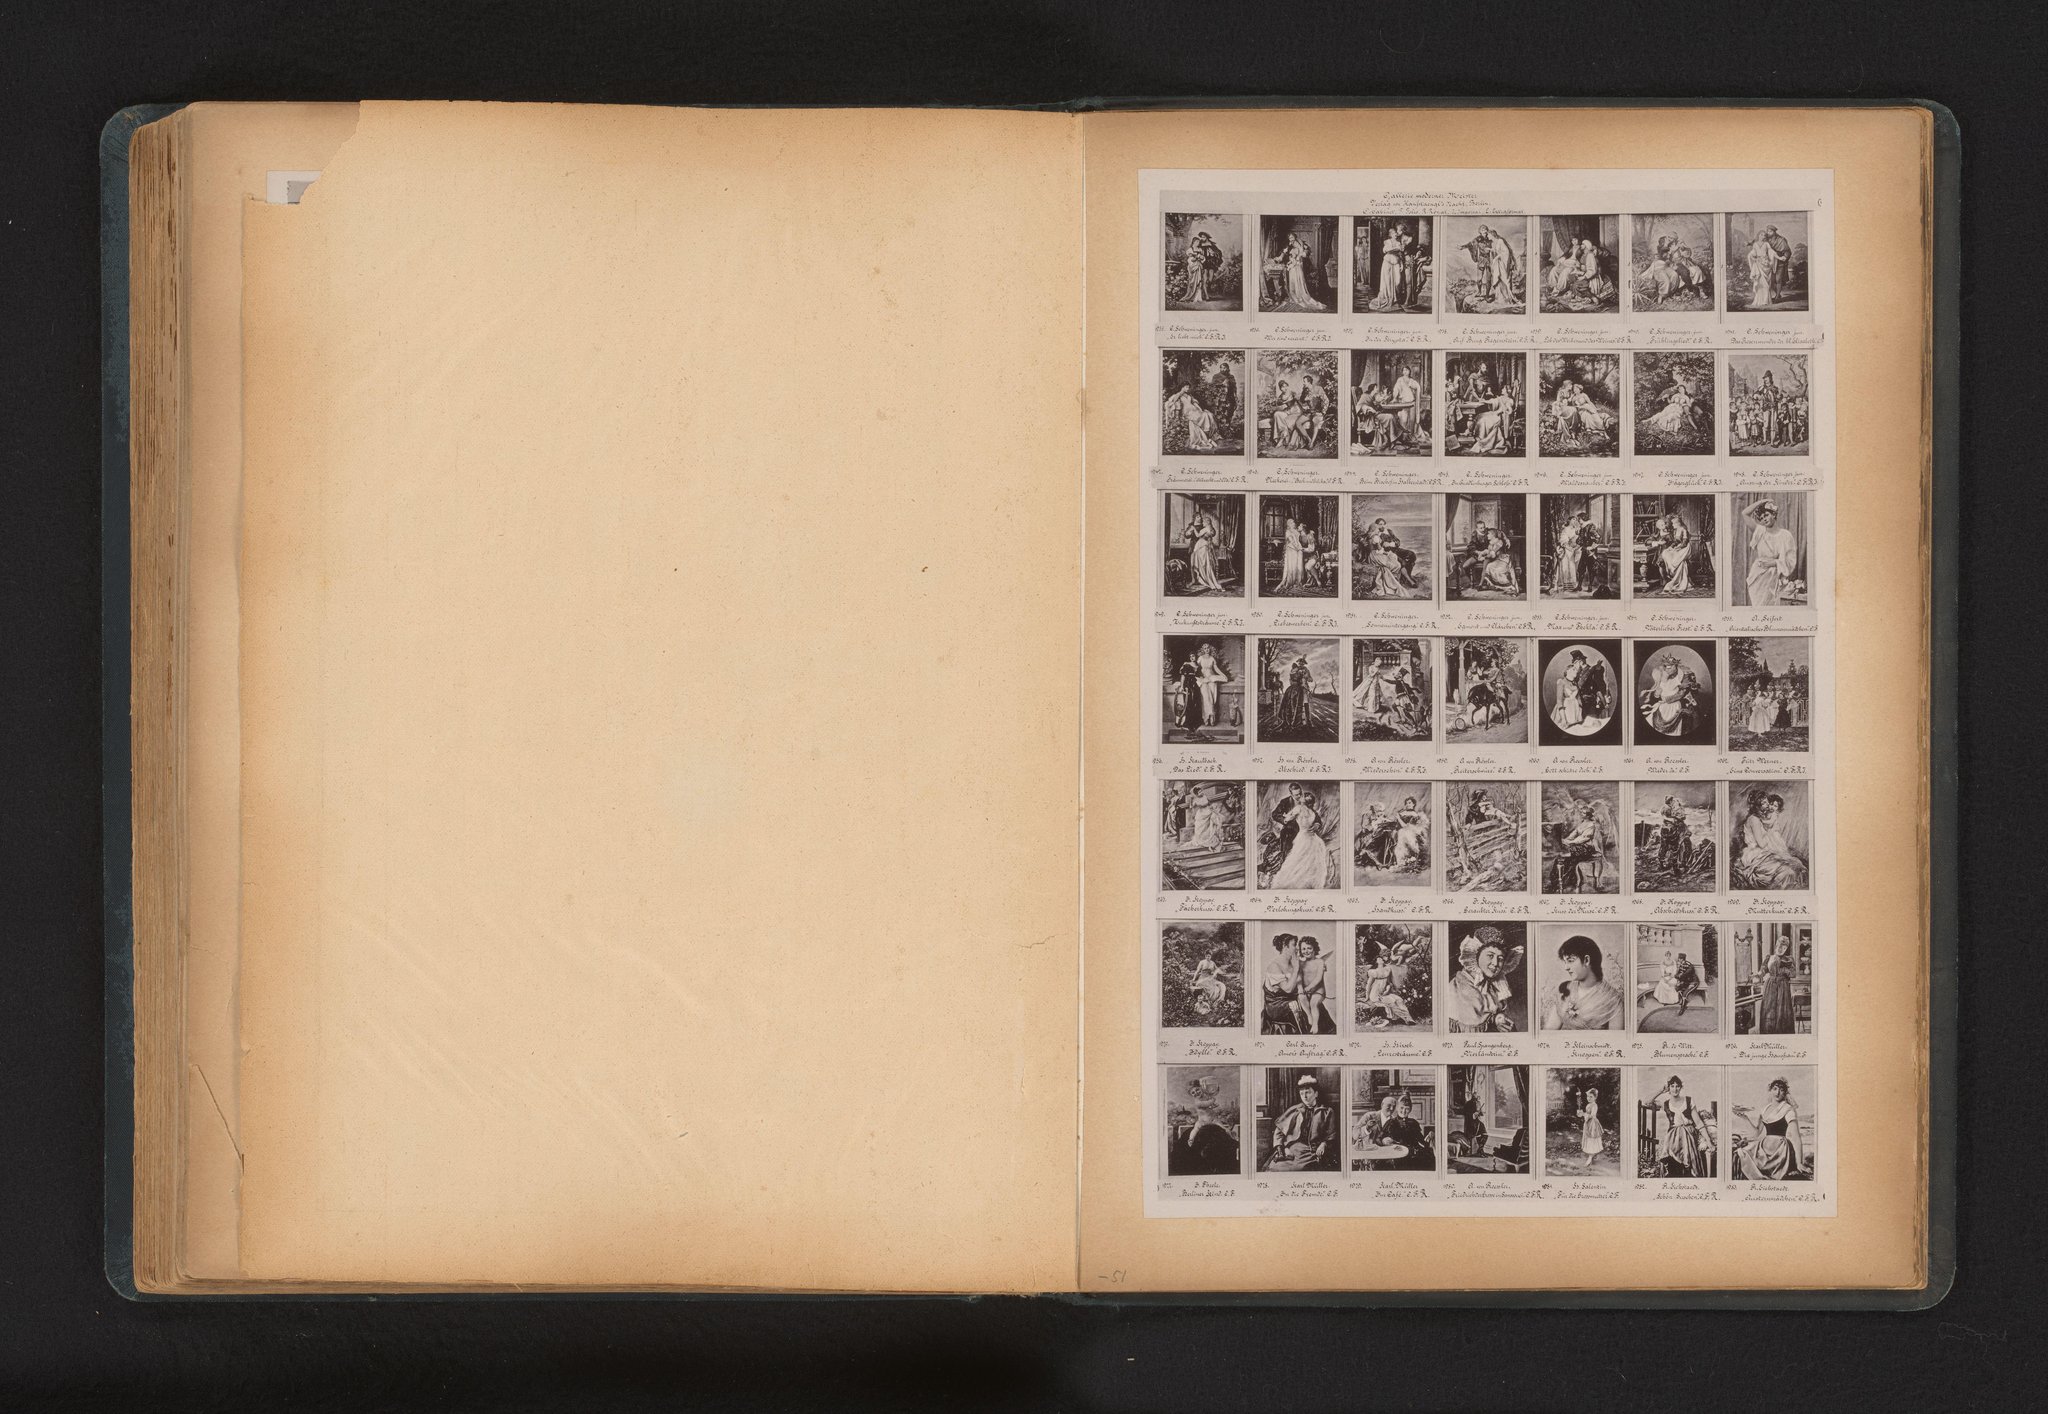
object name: reproduction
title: Fotoreproducties van geschilderde portretten en taferelen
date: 1880-1885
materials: paper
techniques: photograph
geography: berlin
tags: historical persons not known by name - bb - woman, historical persons not known by name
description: Prent op eenenvijftigste ongenummerde pagina.